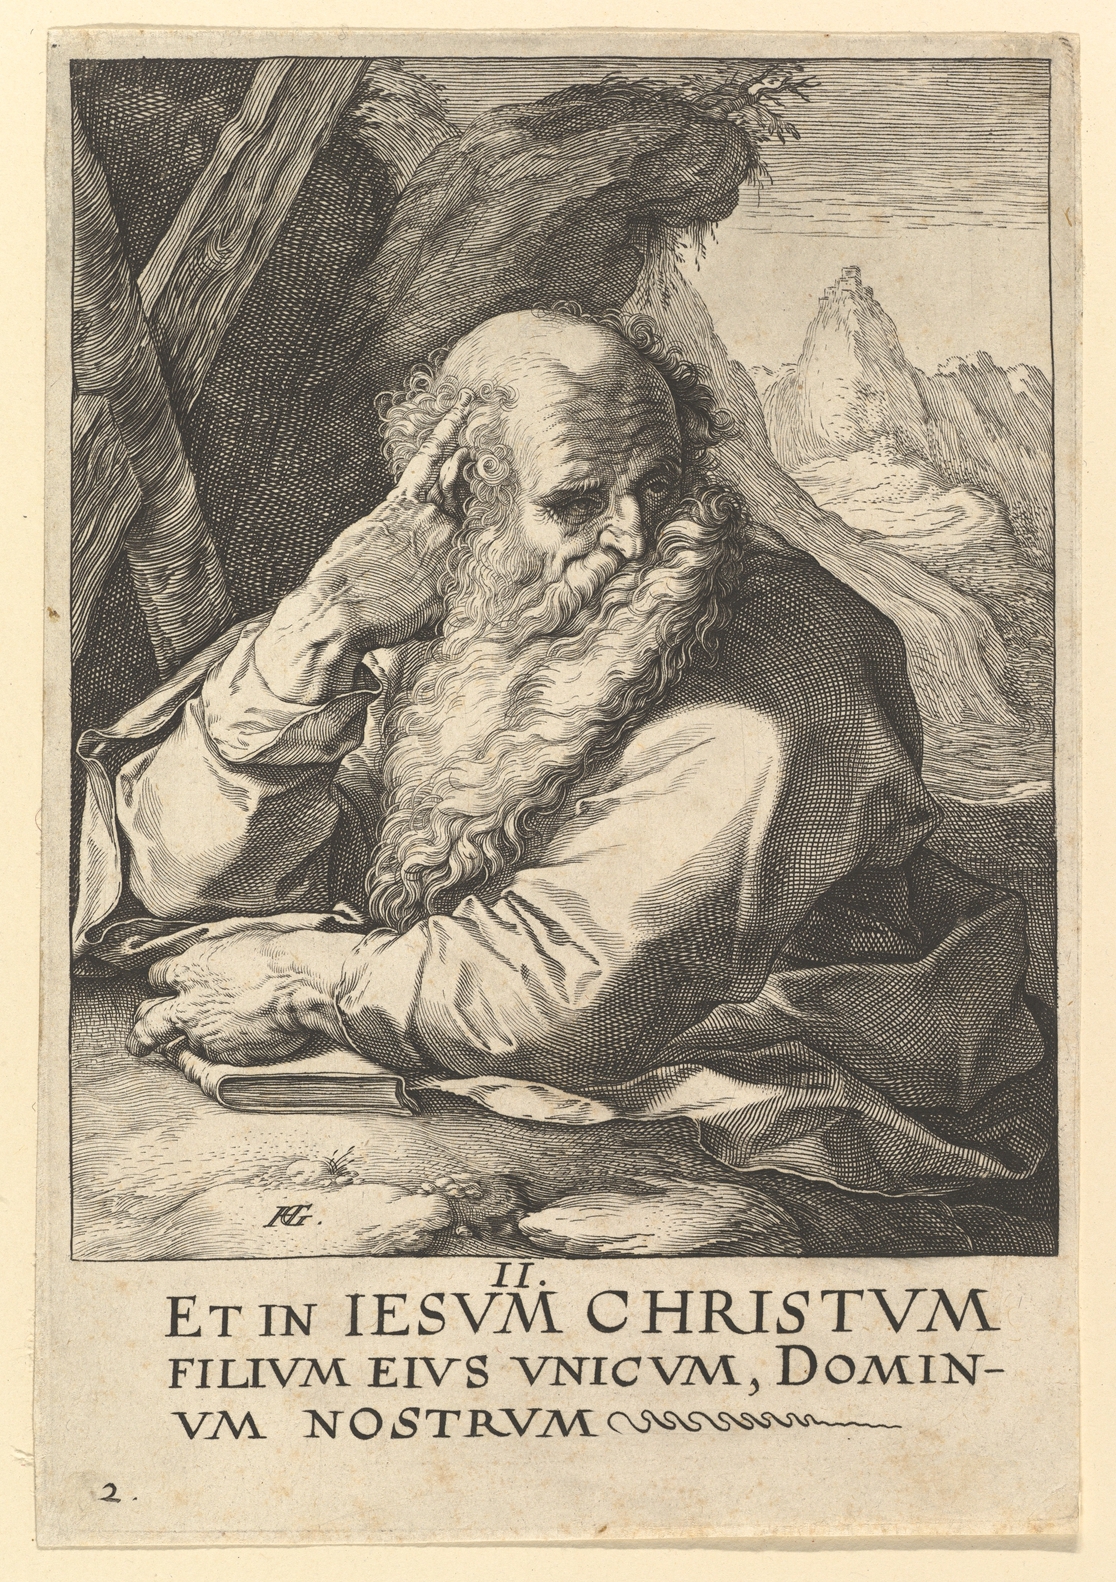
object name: print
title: St. Andrew, from "Christ, the Apostles and St. Paul with the Creed"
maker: hendrick goltzius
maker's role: artist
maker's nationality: netherlandish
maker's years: 1558-1617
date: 1589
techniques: engraving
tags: portraits,apostles,saints